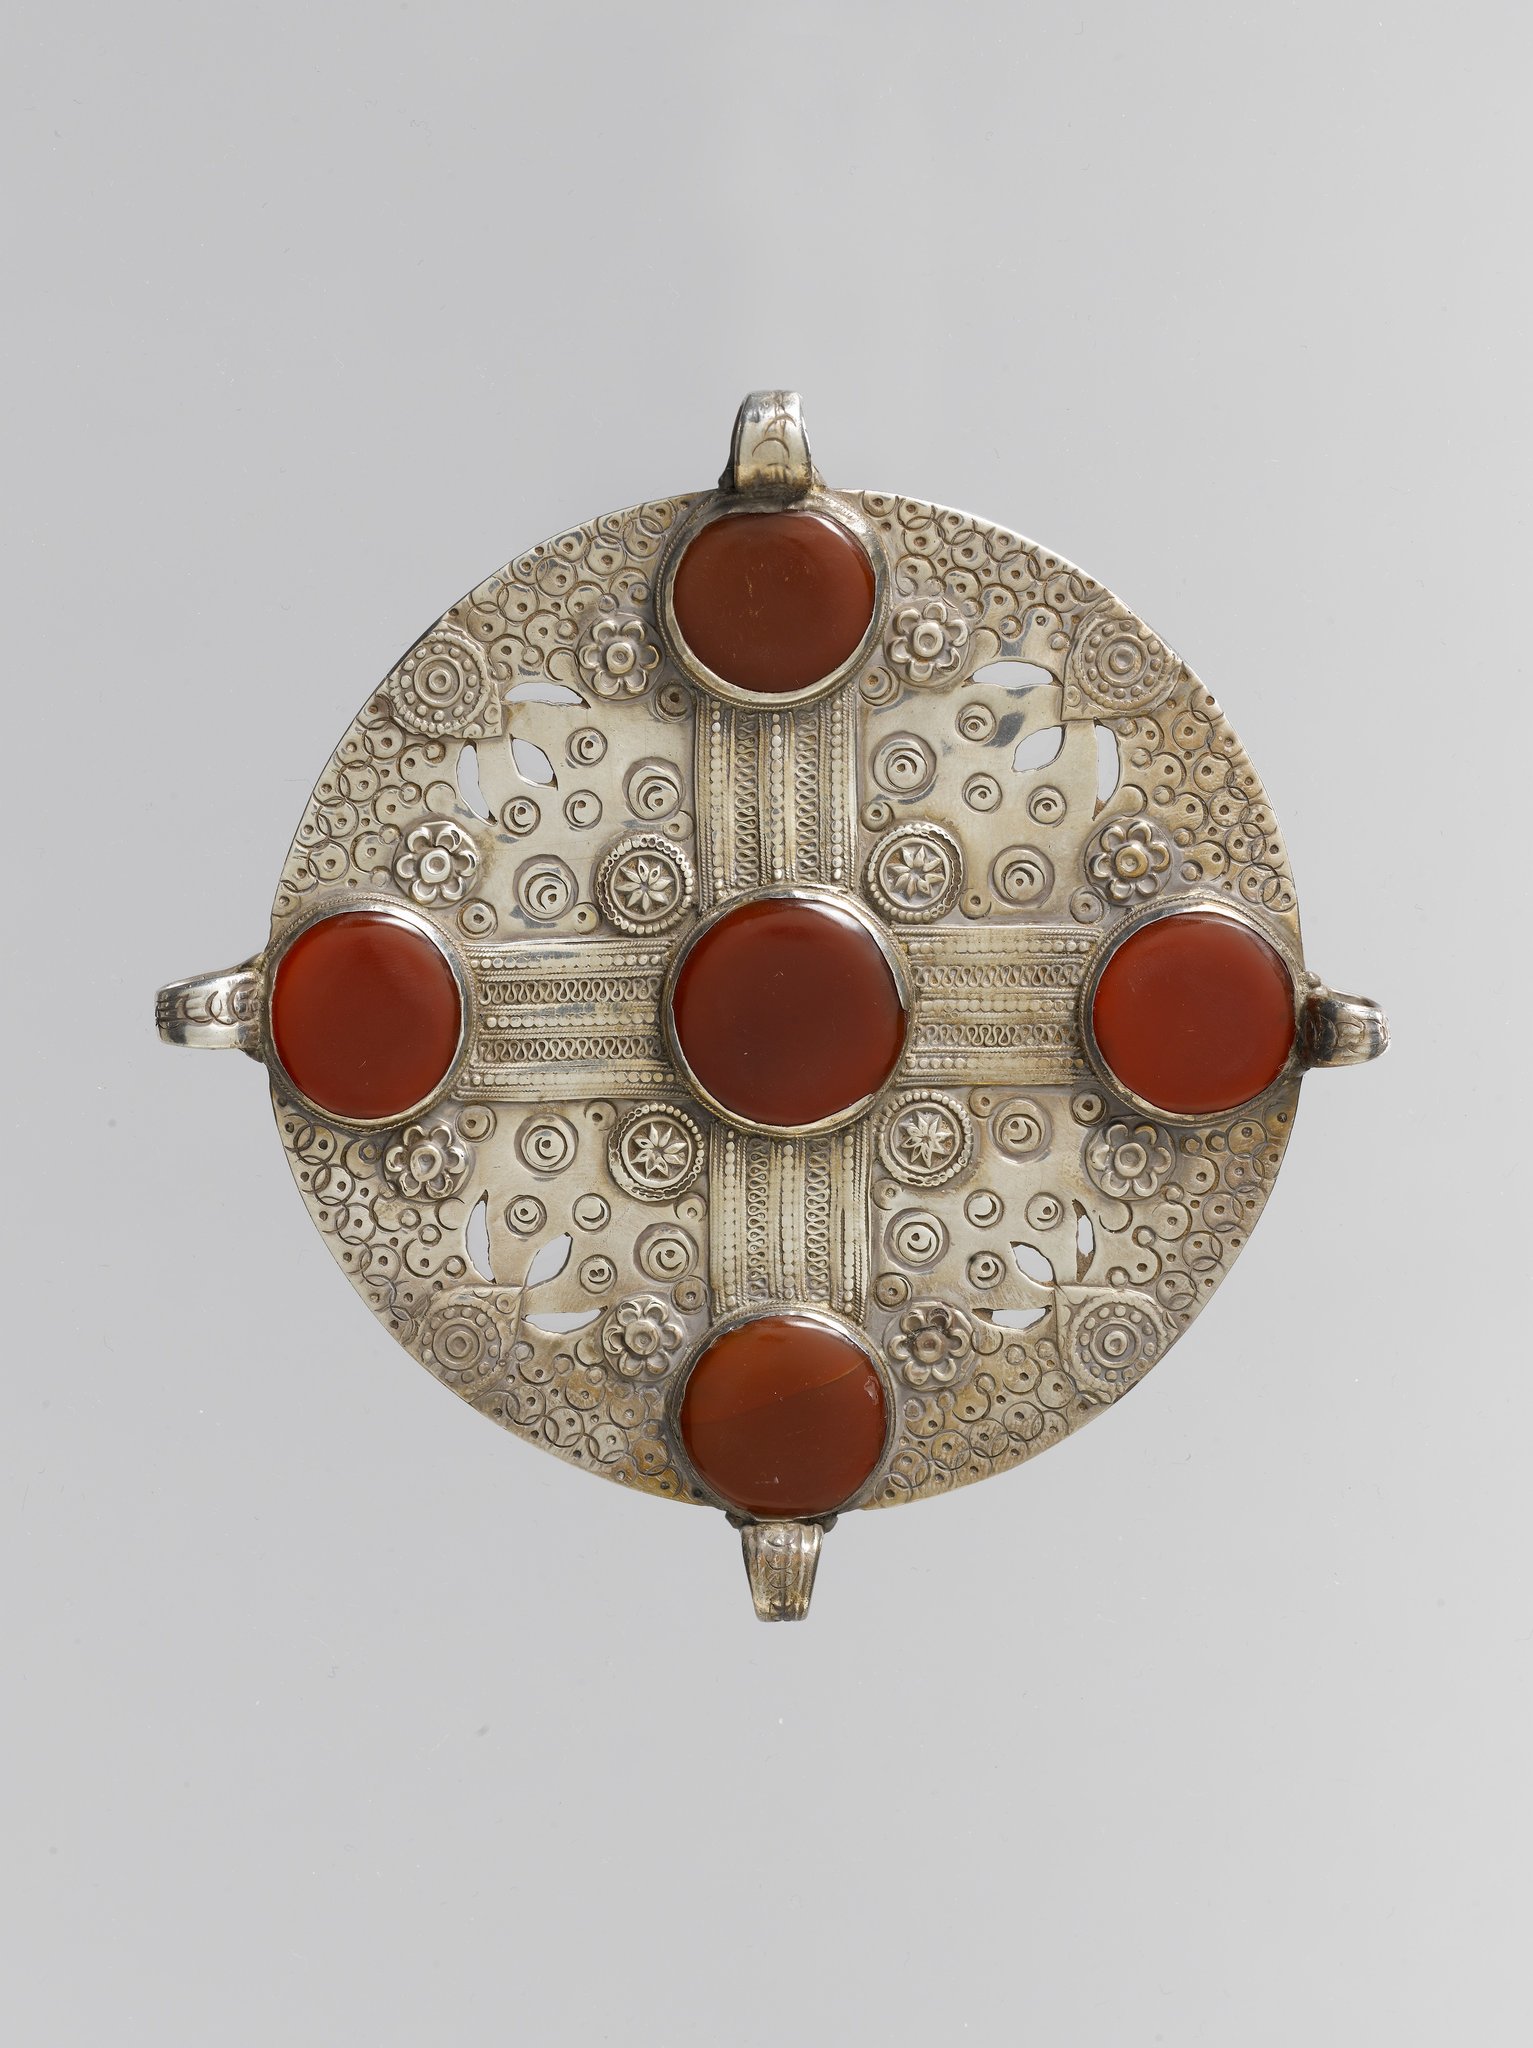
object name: ornament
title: Pectoral Disc Ornament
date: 1801-1900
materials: carnelian, silver, metal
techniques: chasing, cutting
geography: central asia